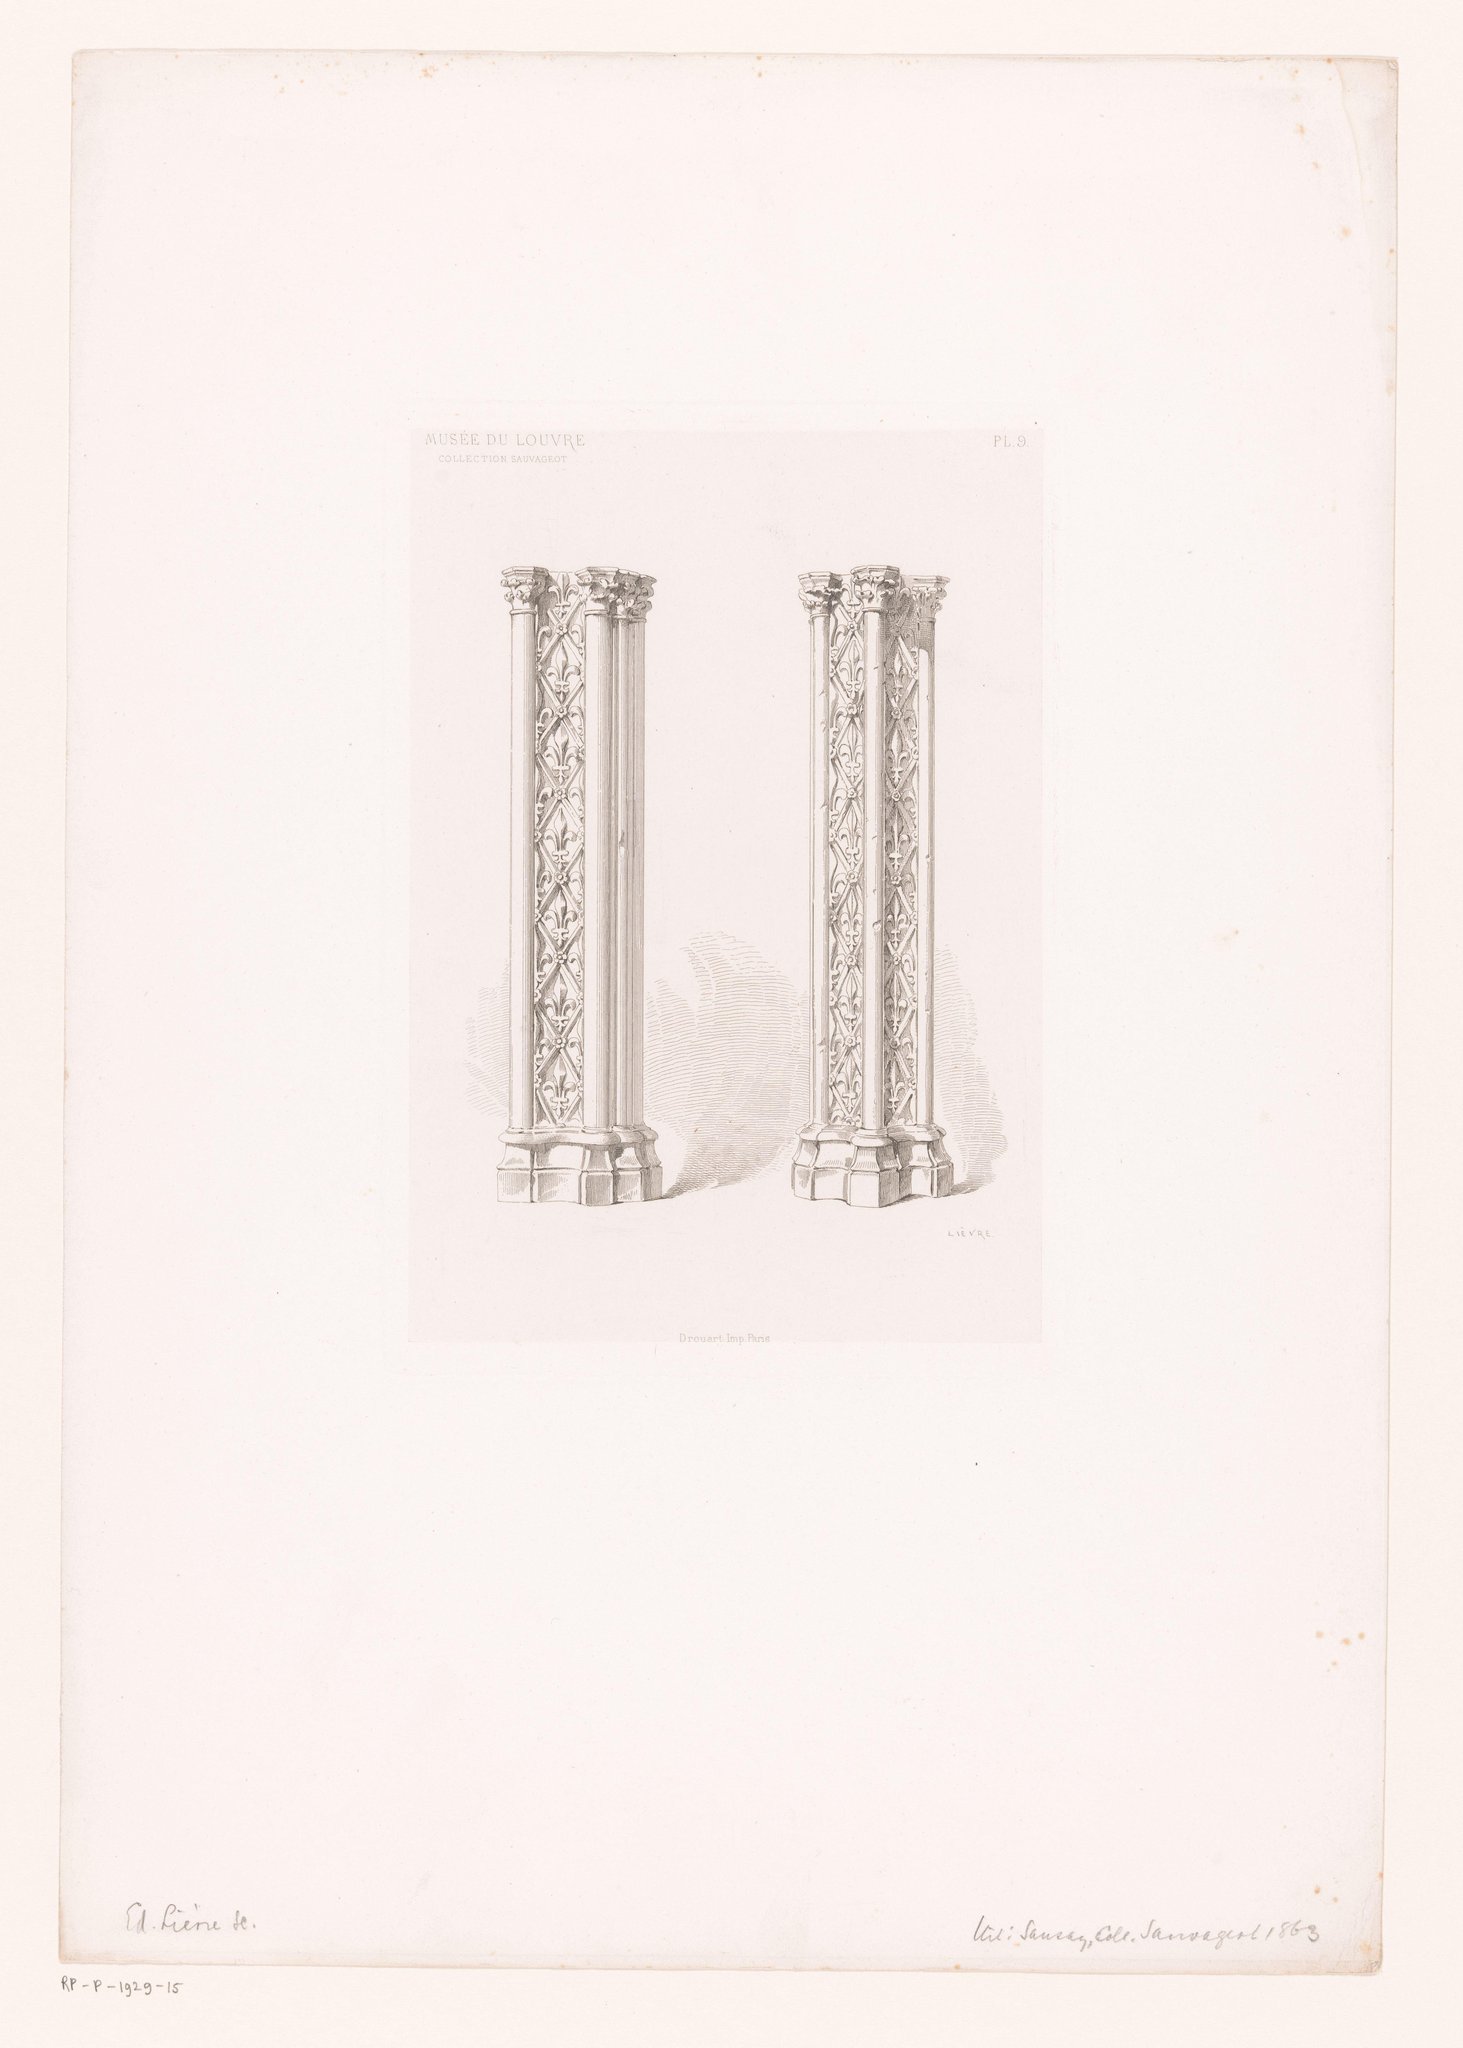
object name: book illustration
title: Twee zuilen, gedecoreerd met de Fleur de lis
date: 1863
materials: paper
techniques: etching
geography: paris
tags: fleur-de-lis ~ ornament, column, pillar ~ architecture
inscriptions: collector's mark: Lugt 2228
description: Prent uit: Sauzay, Alexandre. Musée Impérial Du Louvre - Collection Sauvageot Dessinée Et Gravée A L'Eau-Forte Par Édouard Lièvre Accompagnée D'Un Texte Historique Et Descriptif Par A. Sauzay. Parijs: Noblet et Baudry, 1863. In deze publicatie worden metalen objecten beschreven uit de Gotiek en de Renaissance uit de collectie van Charles Sauvageot, in 1856 geschonken aan het Musée du Louvre.